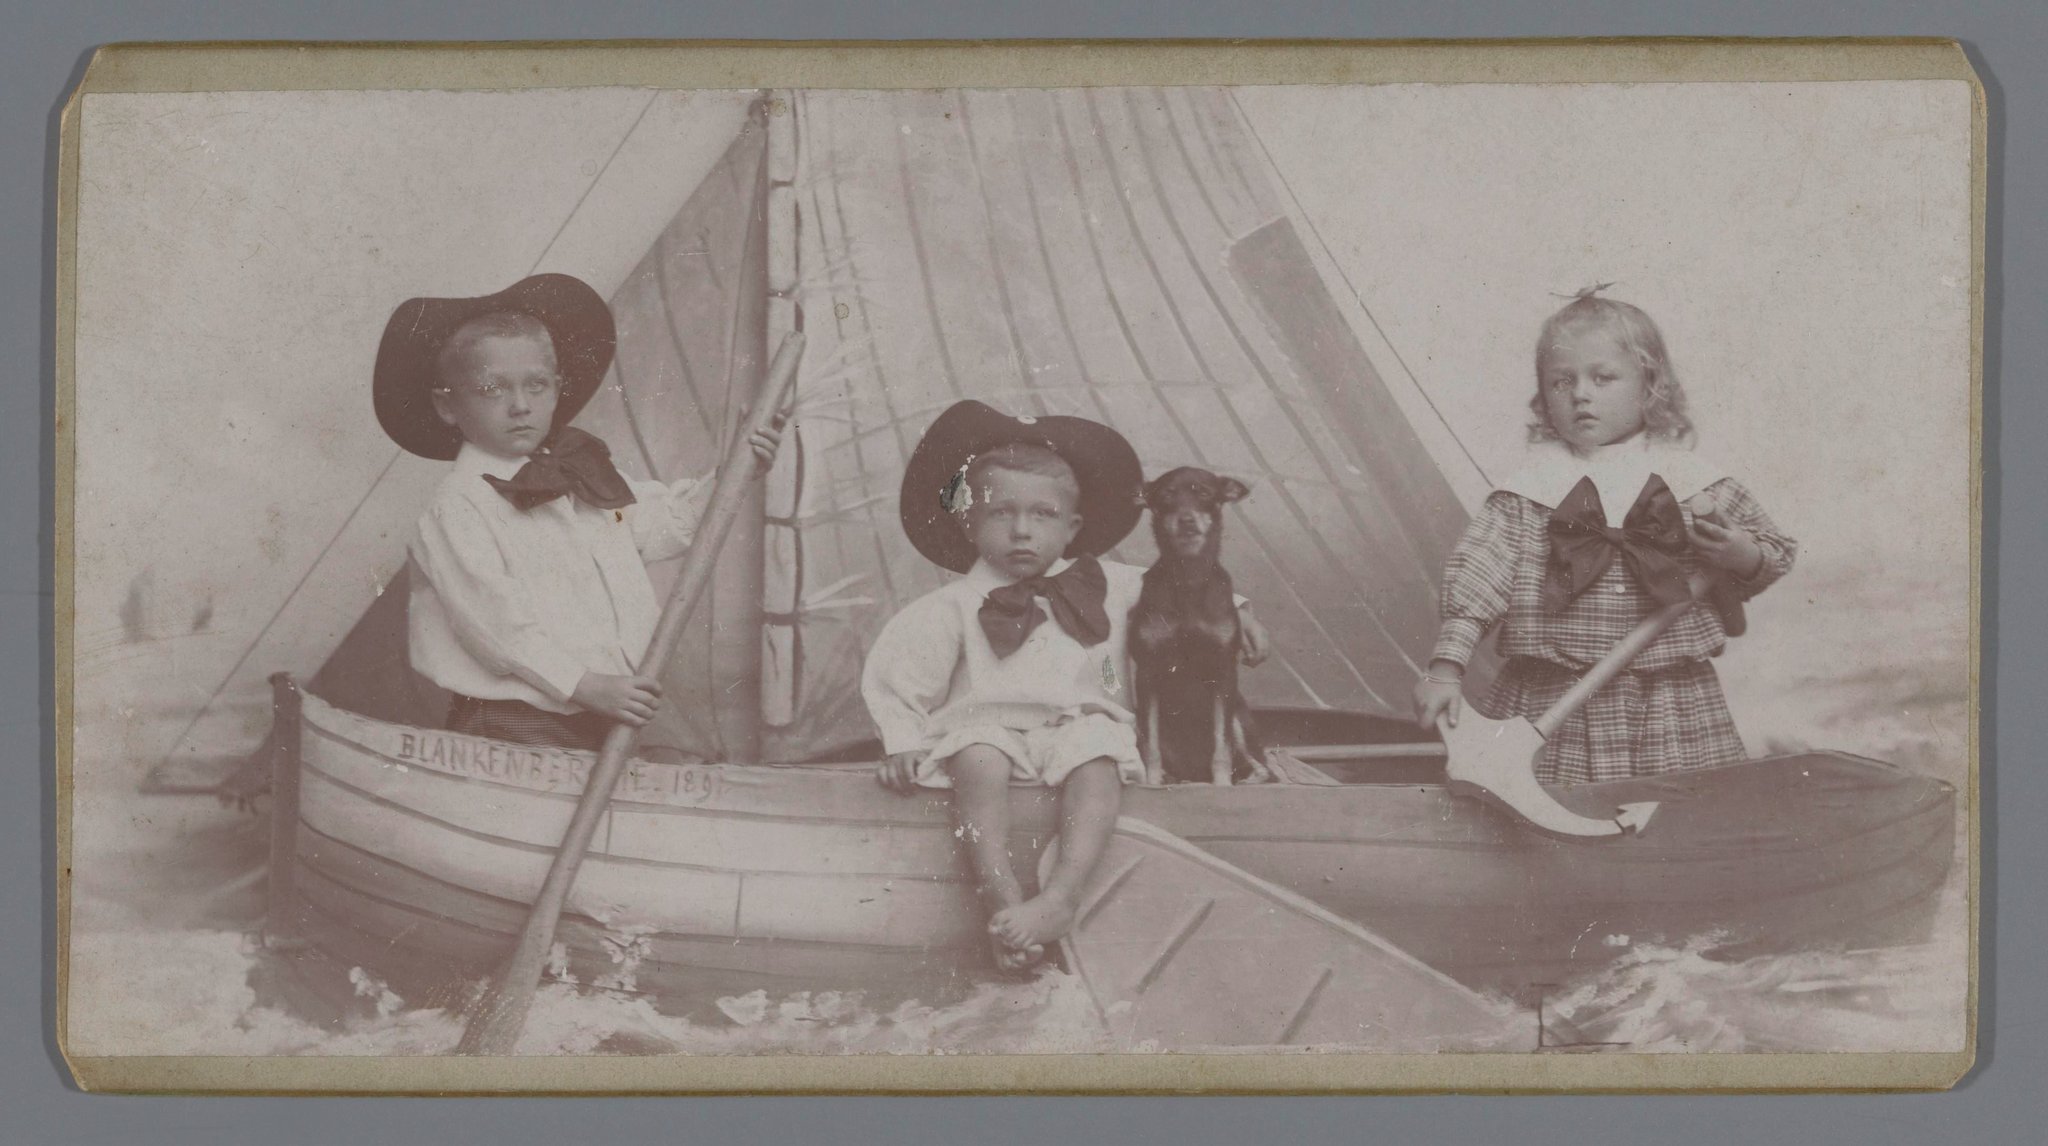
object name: photograph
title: Studioportret van drie kinderen en een hond in een boot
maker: Anonymous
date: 1898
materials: cardboard, photographic support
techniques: collodion silver print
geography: blankenberge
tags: studio ~ photographer, child, ships (in general), dog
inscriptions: inscription: ‘Blankenberghe 19 septembre 1898’